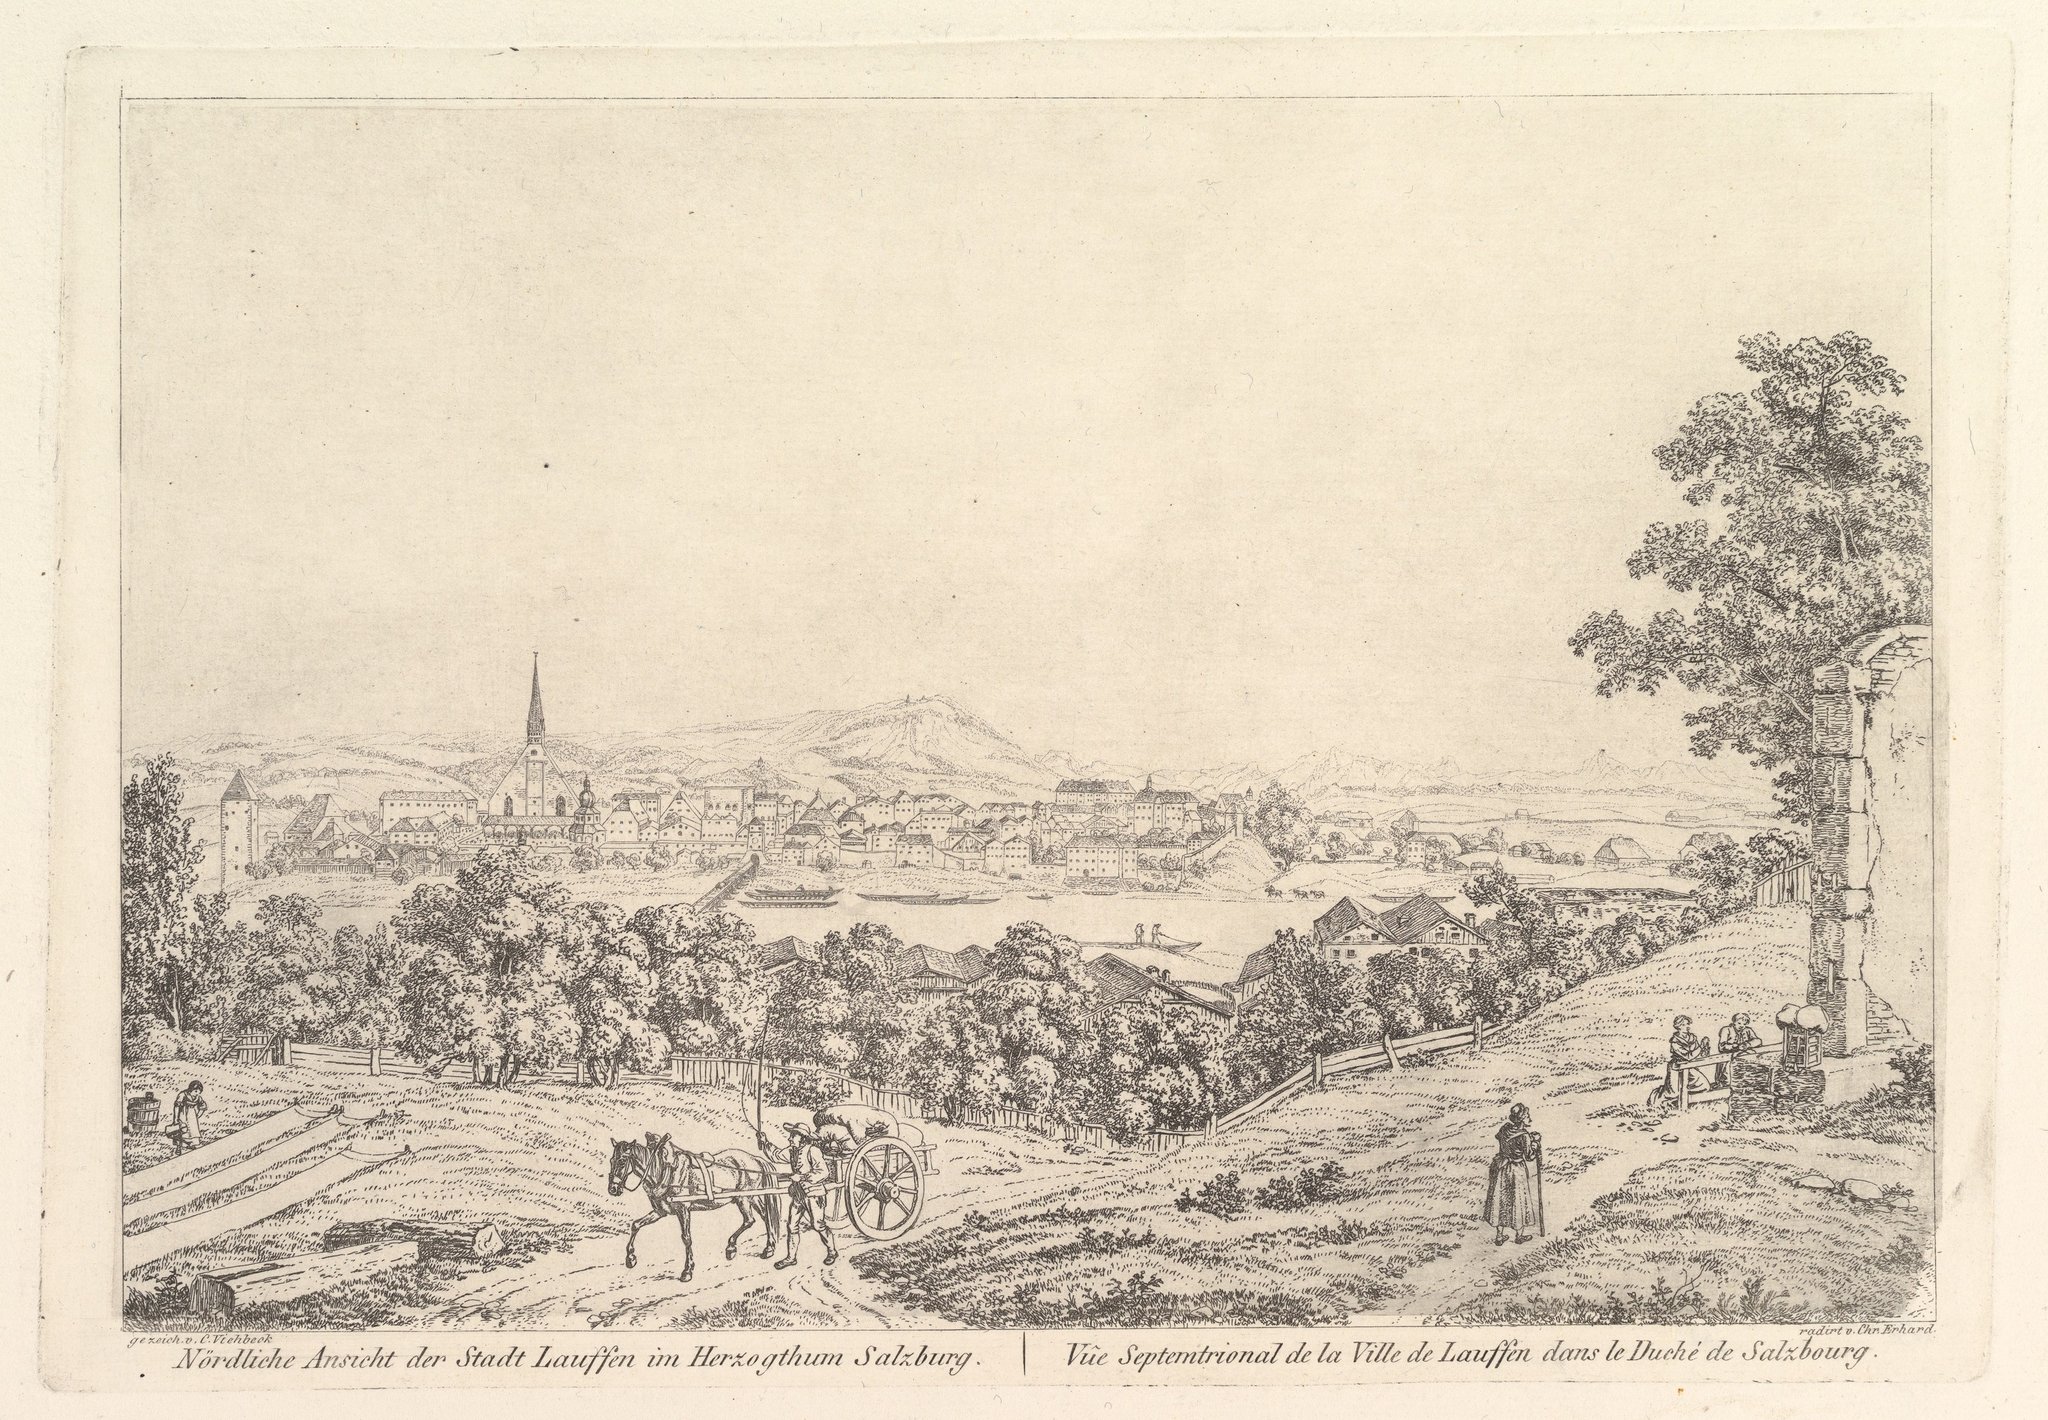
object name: print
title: Paths in the Dukedom of Salzburg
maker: johann christoph erhard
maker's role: artist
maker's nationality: german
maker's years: 1795-1822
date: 1801-1833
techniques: etching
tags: men,horses,landscapes,trees,carriages